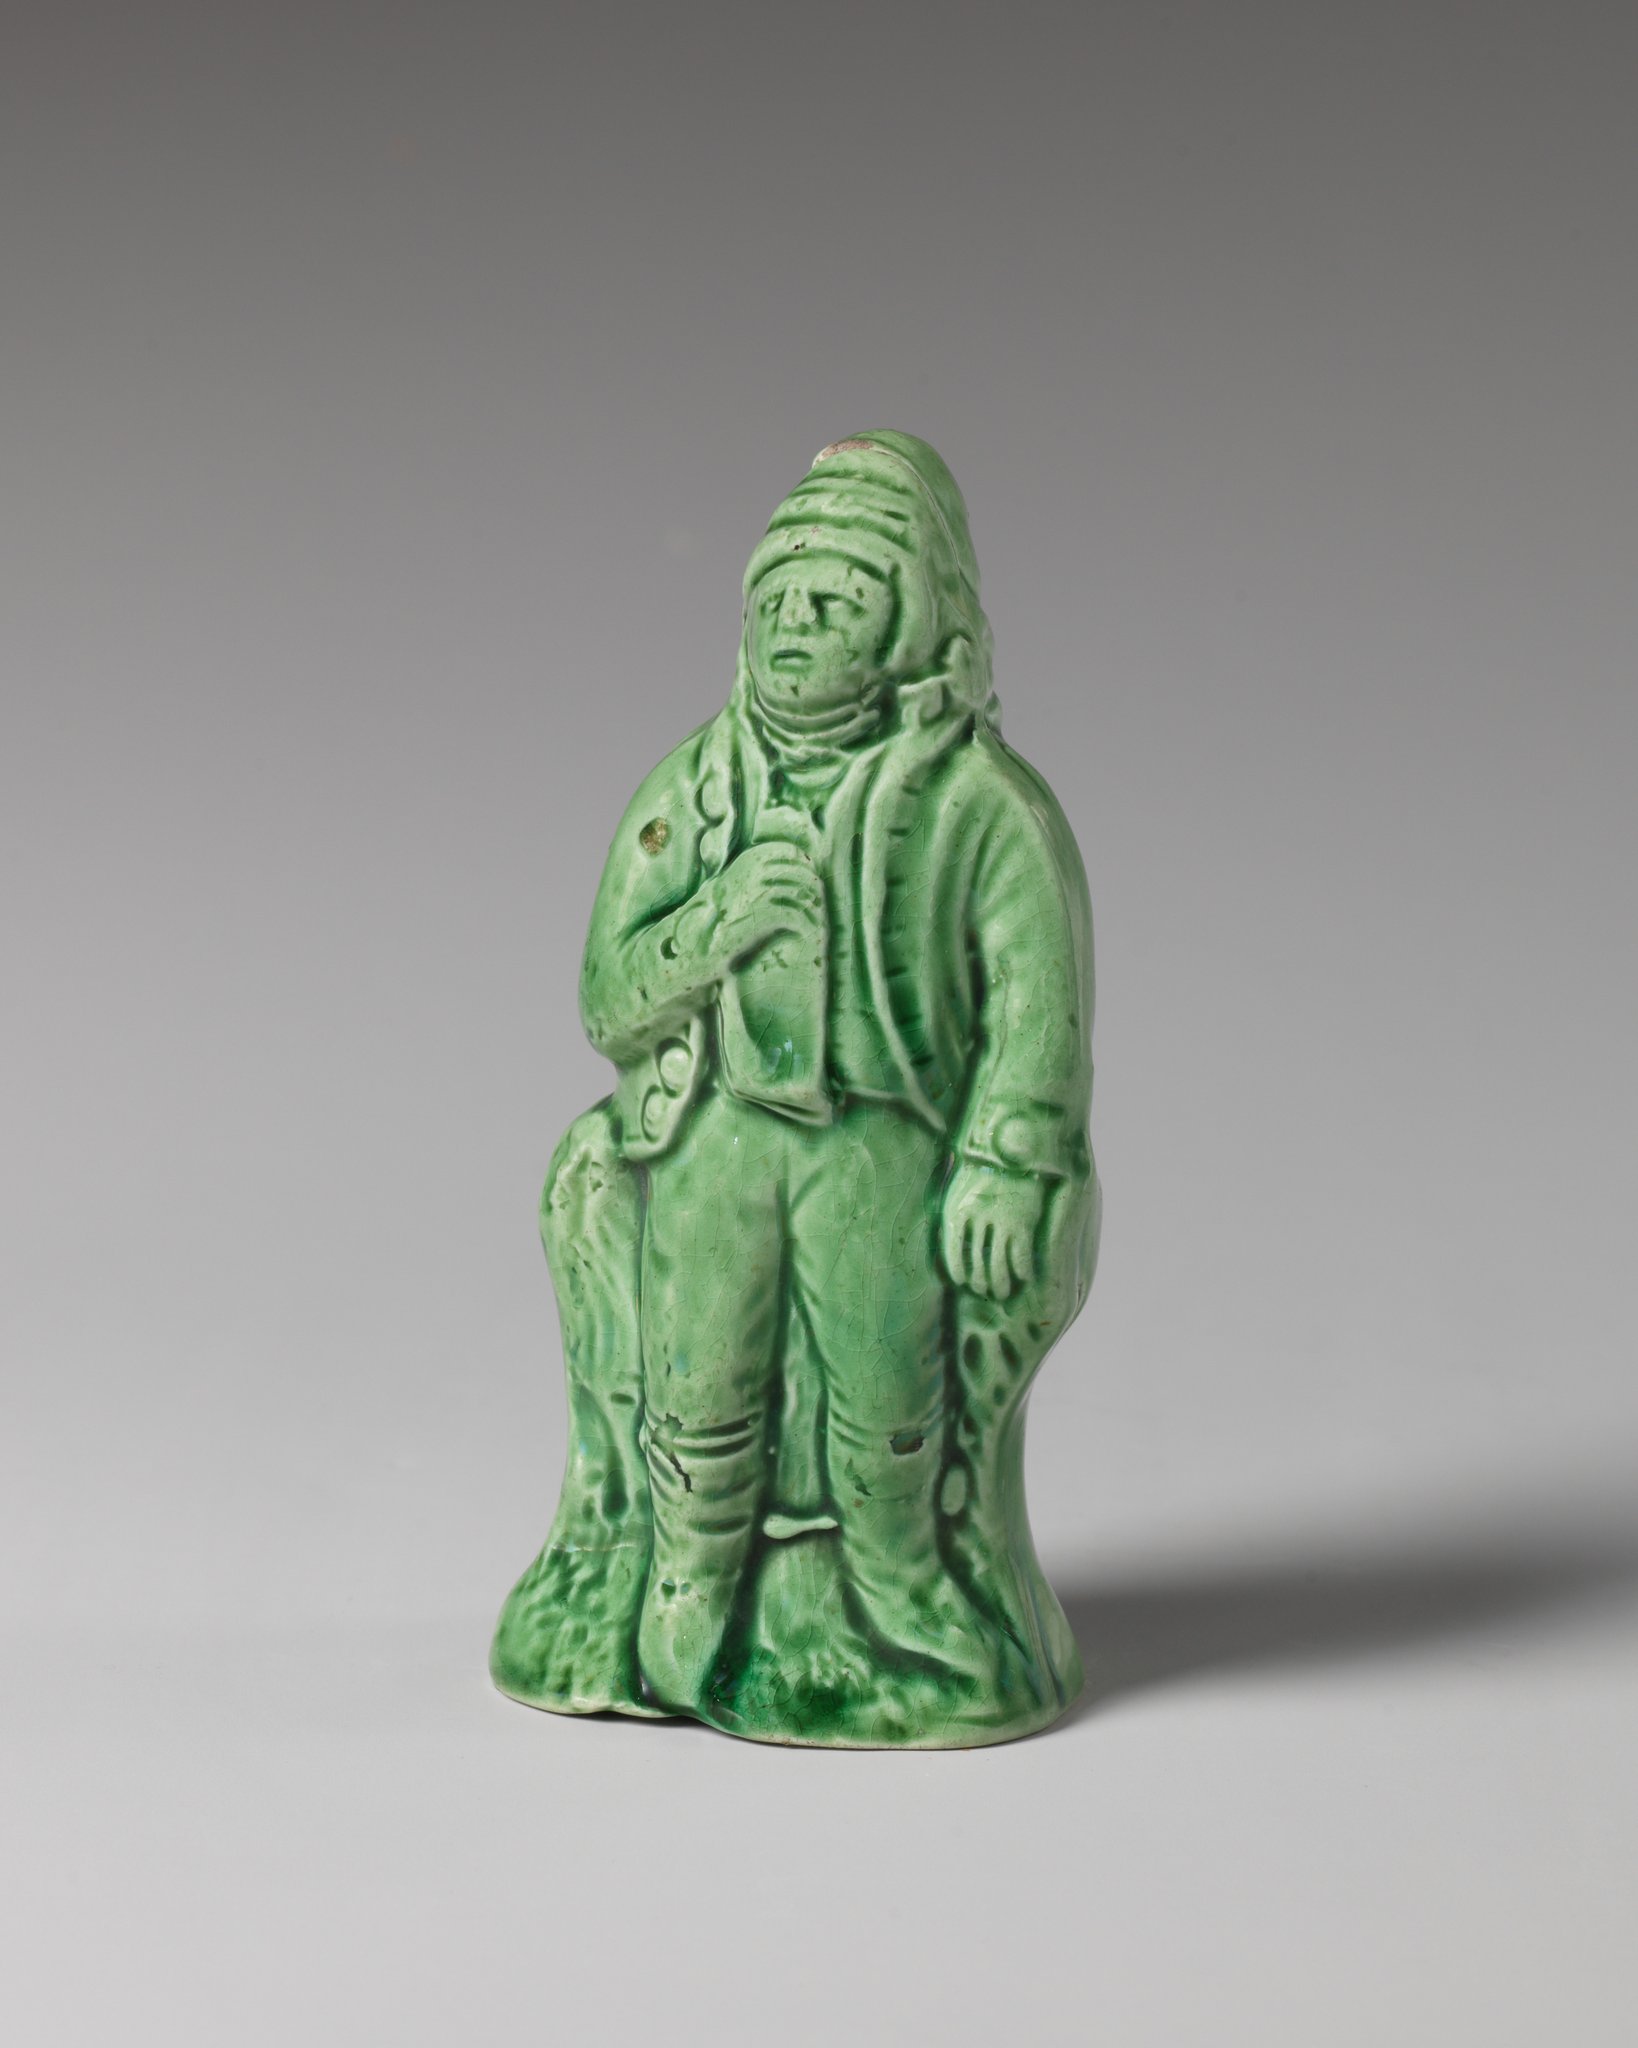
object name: figure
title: Figure of a standing man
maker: ralph wood the younger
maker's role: maker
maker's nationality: british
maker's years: 1748-1795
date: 1780-1790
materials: earthenware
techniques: glazing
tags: men